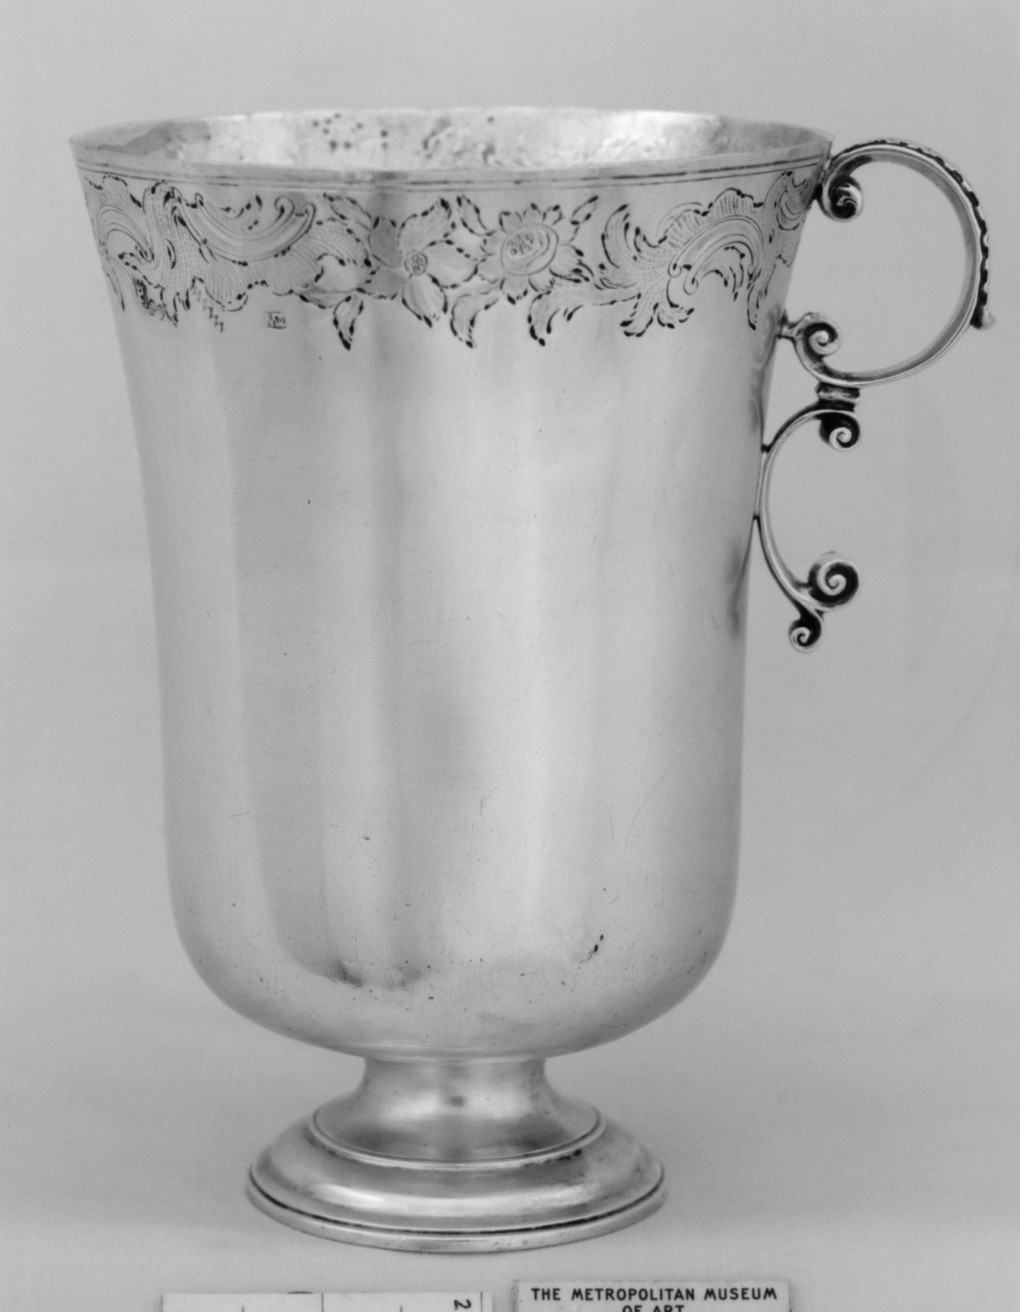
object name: cup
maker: m. d. o.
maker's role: maker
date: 1750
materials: silver